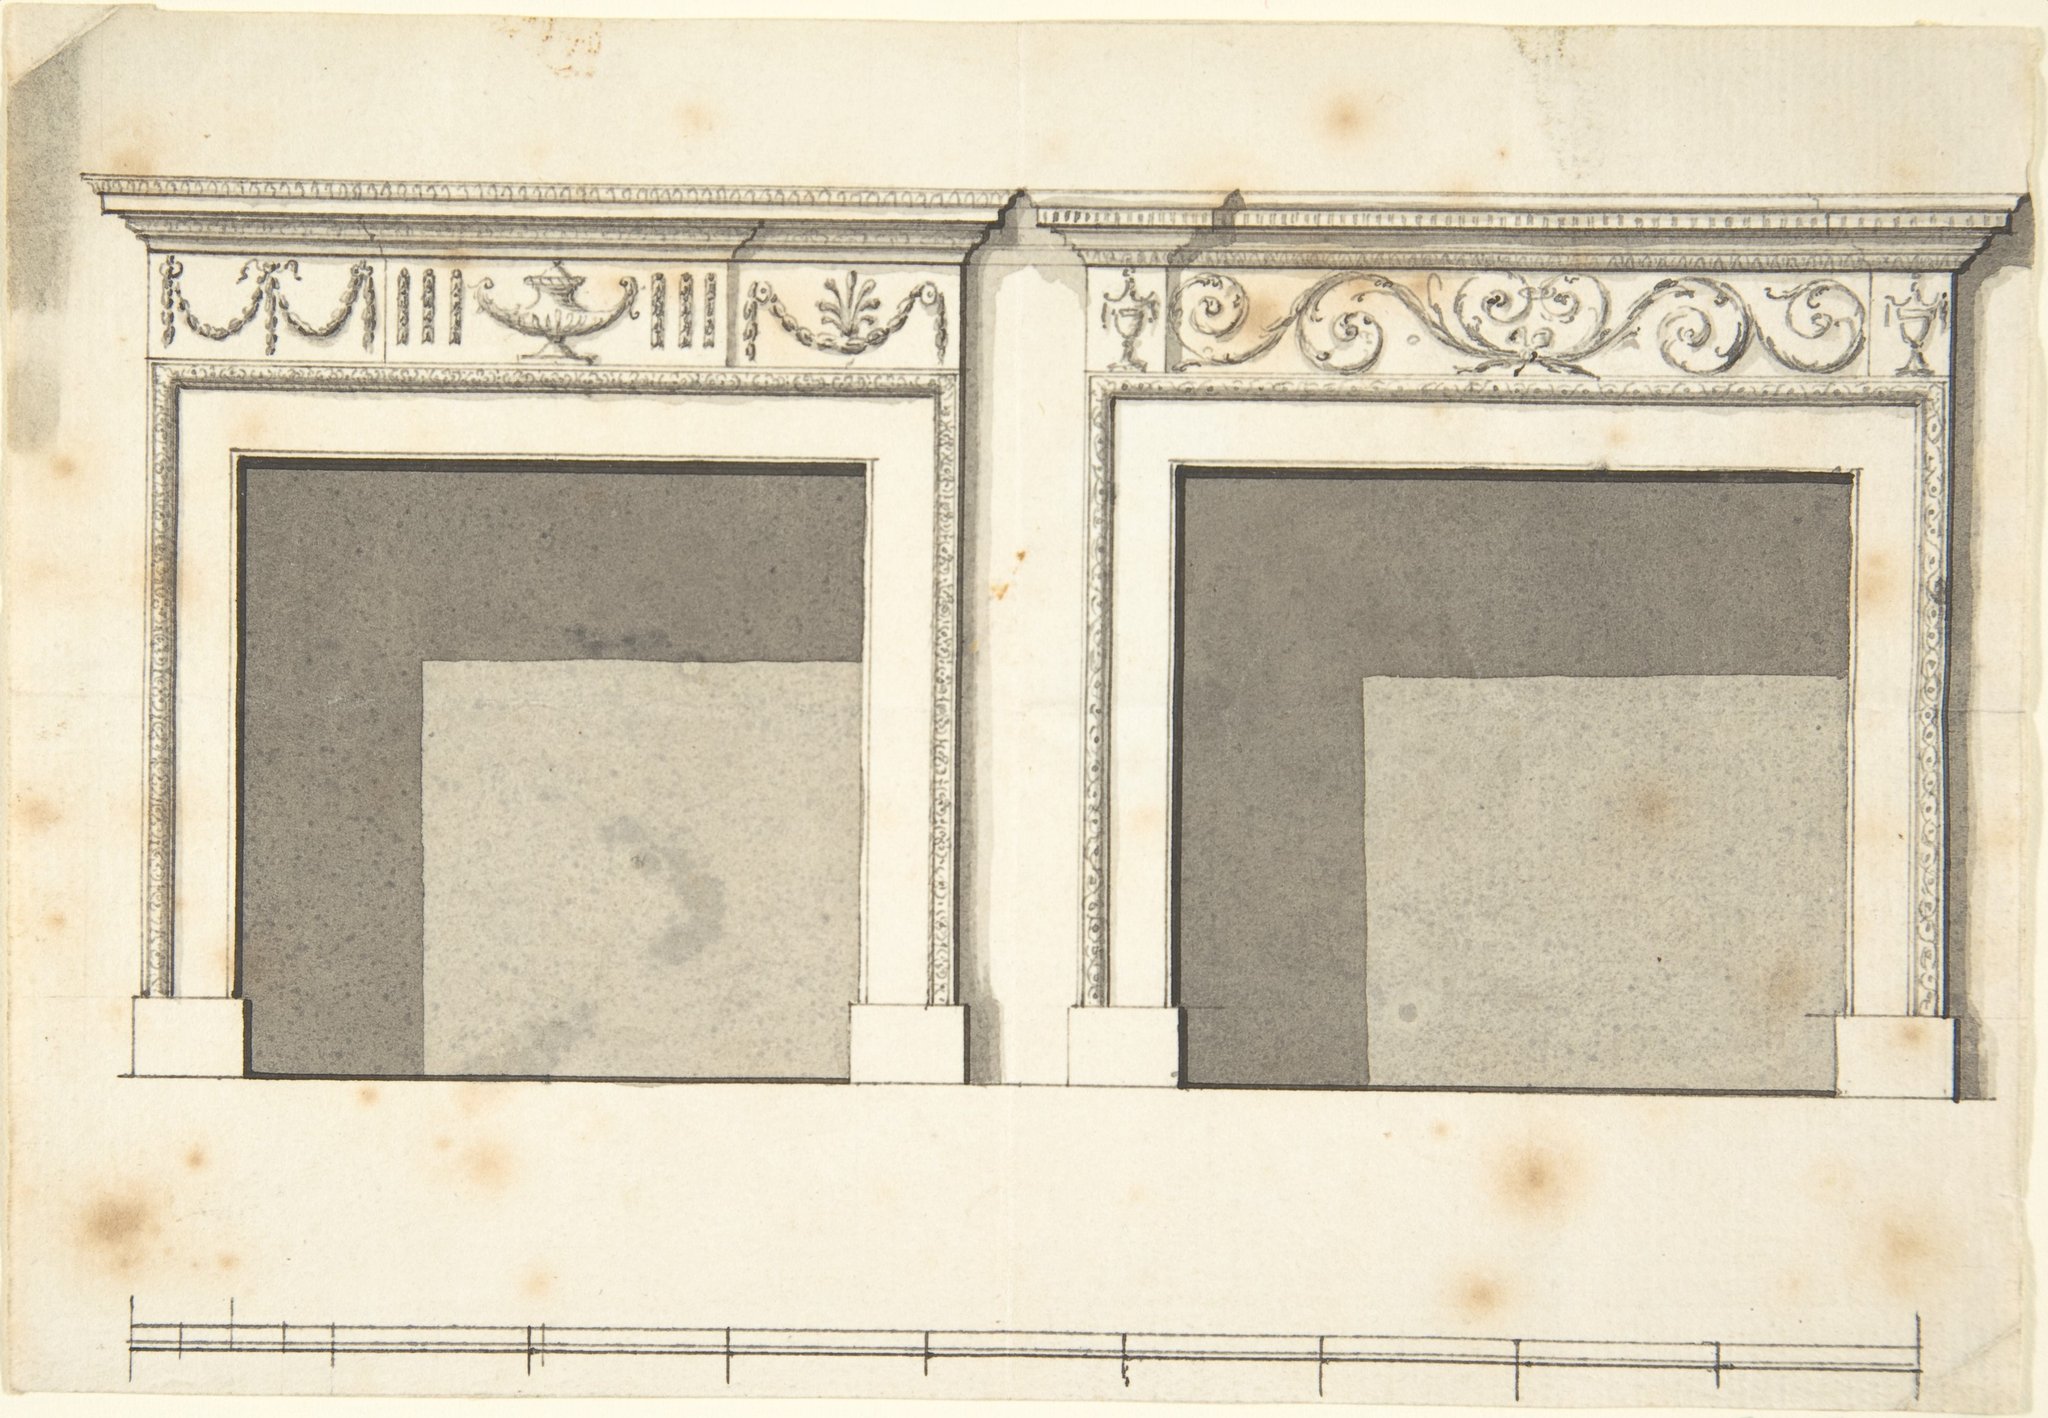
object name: drawing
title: Two Designs for Mantels in the Adam Style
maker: anonymous, british, 18th century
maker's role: artist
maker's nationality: british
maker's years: 1700-1800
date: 1701-1800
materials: ink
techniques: brush, pen, wash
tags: fireplaces